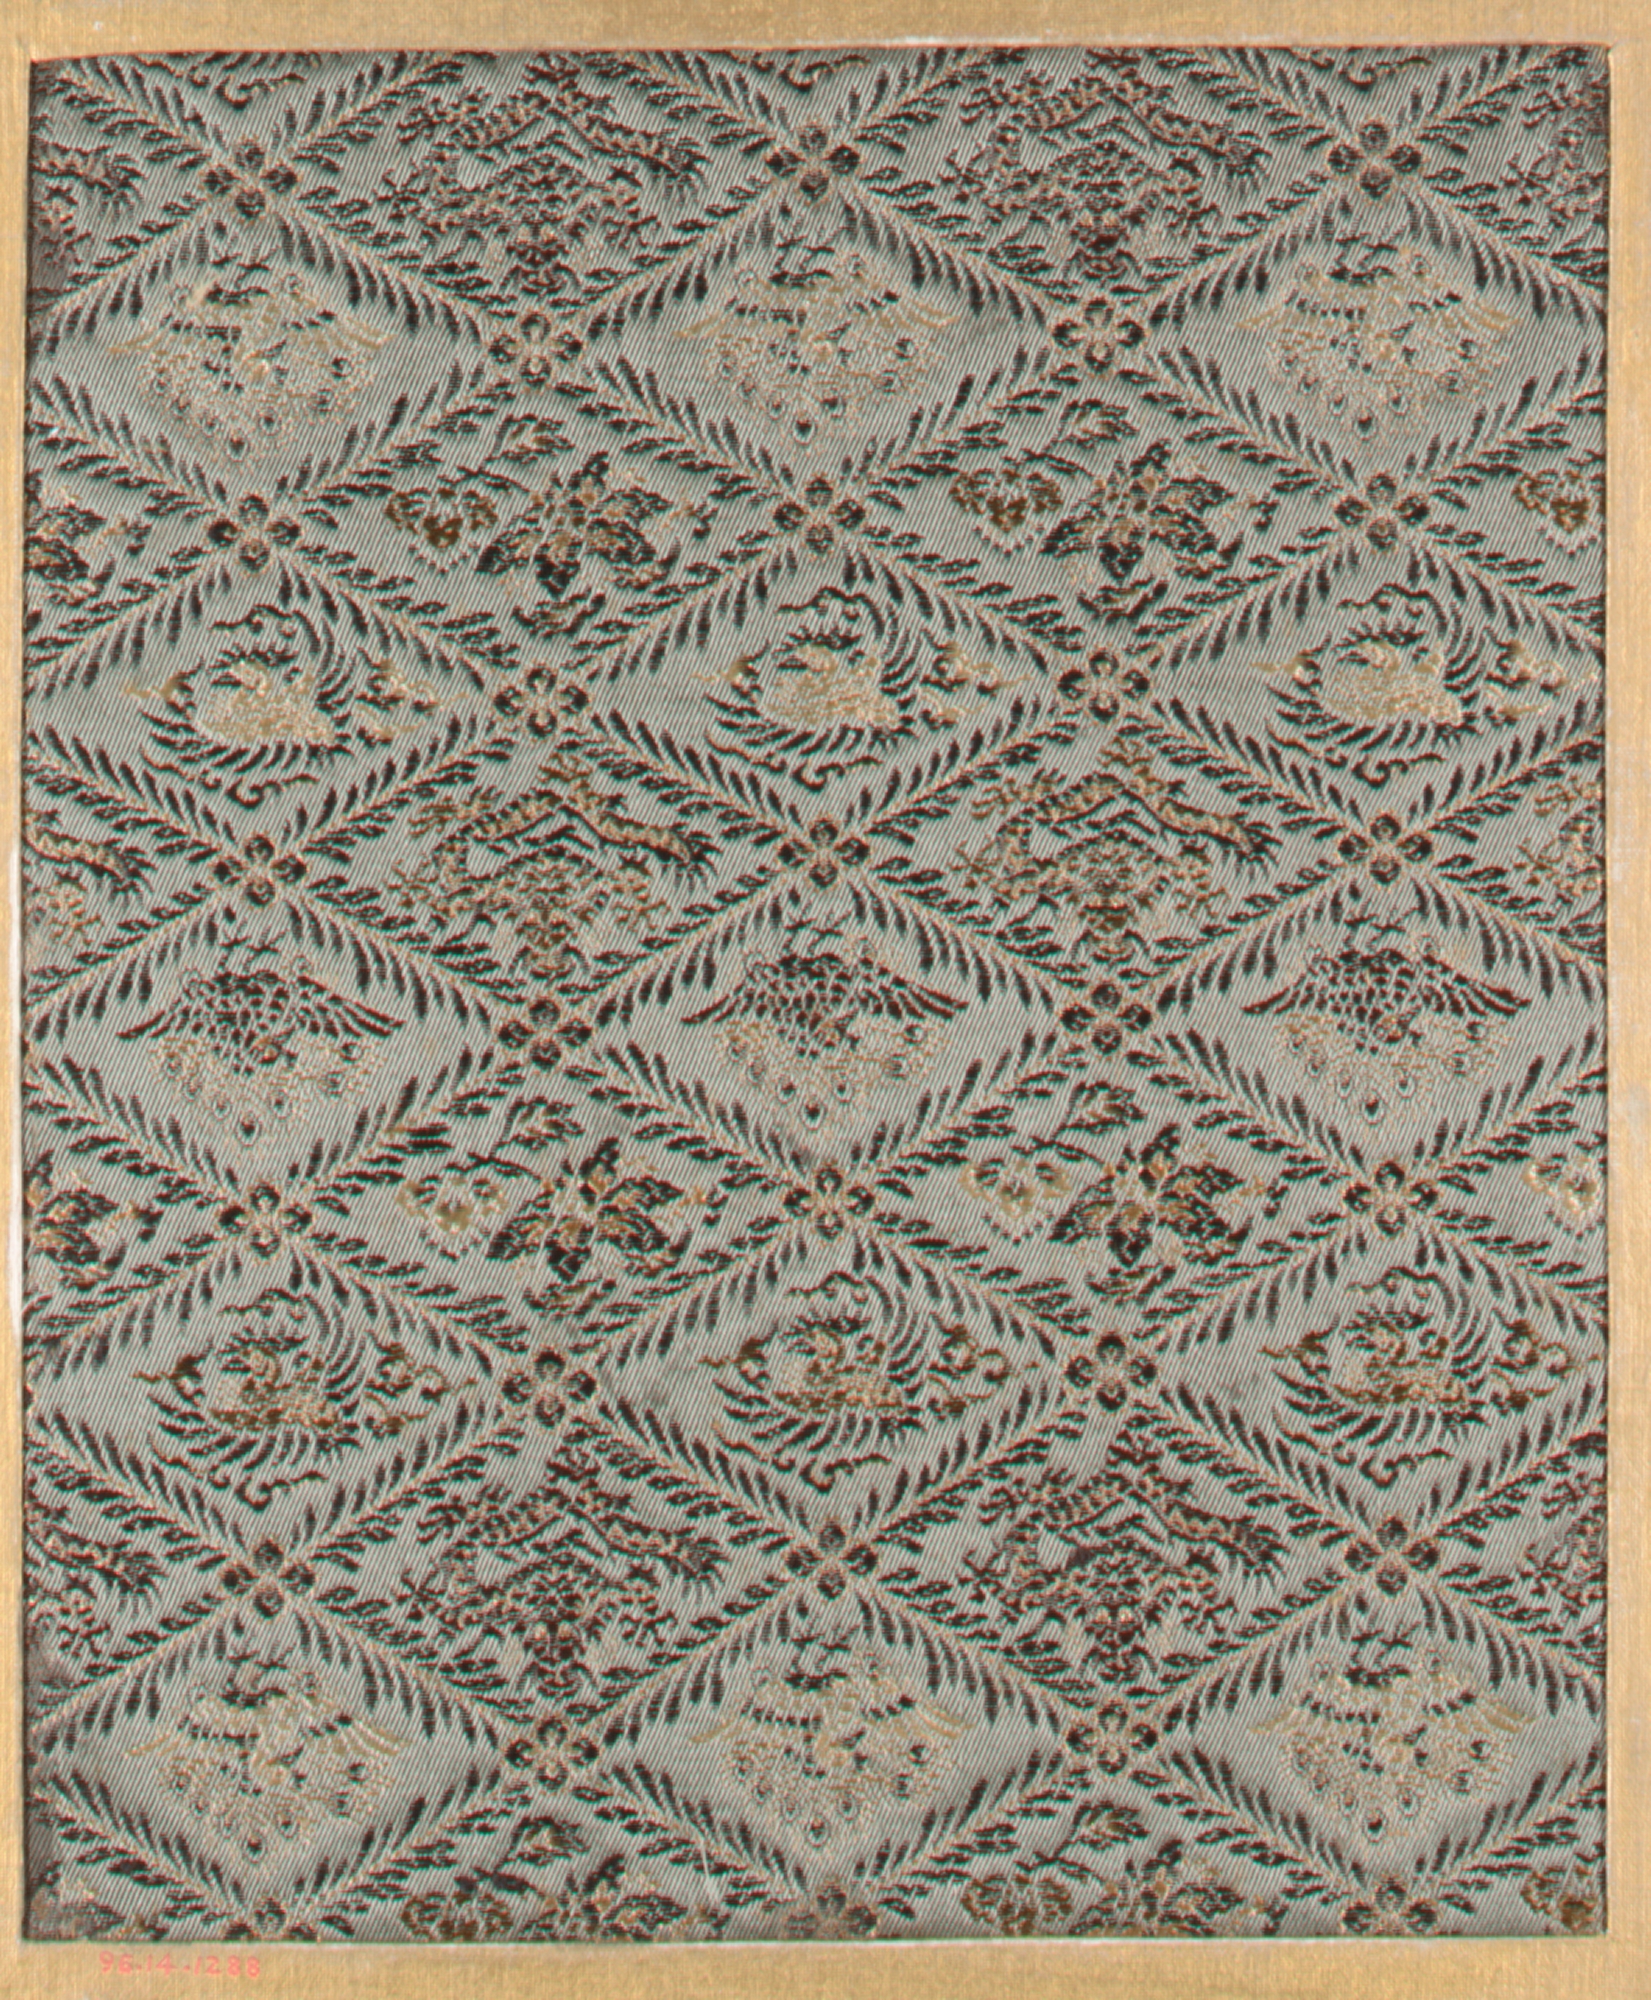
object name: piece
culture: japanese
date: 1701-1900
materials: silk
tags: birds